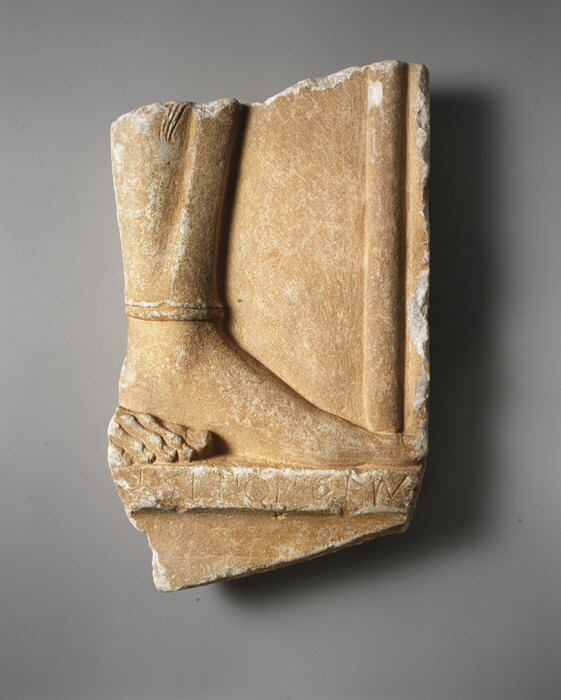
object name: grave stele of a hoplite foot soldier, fragment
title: Fragmentary marble grave stele of a hoplite (foot soldier)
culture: greek, attic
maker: aristokles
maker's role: artist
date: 510 BCE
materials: marble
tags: feet